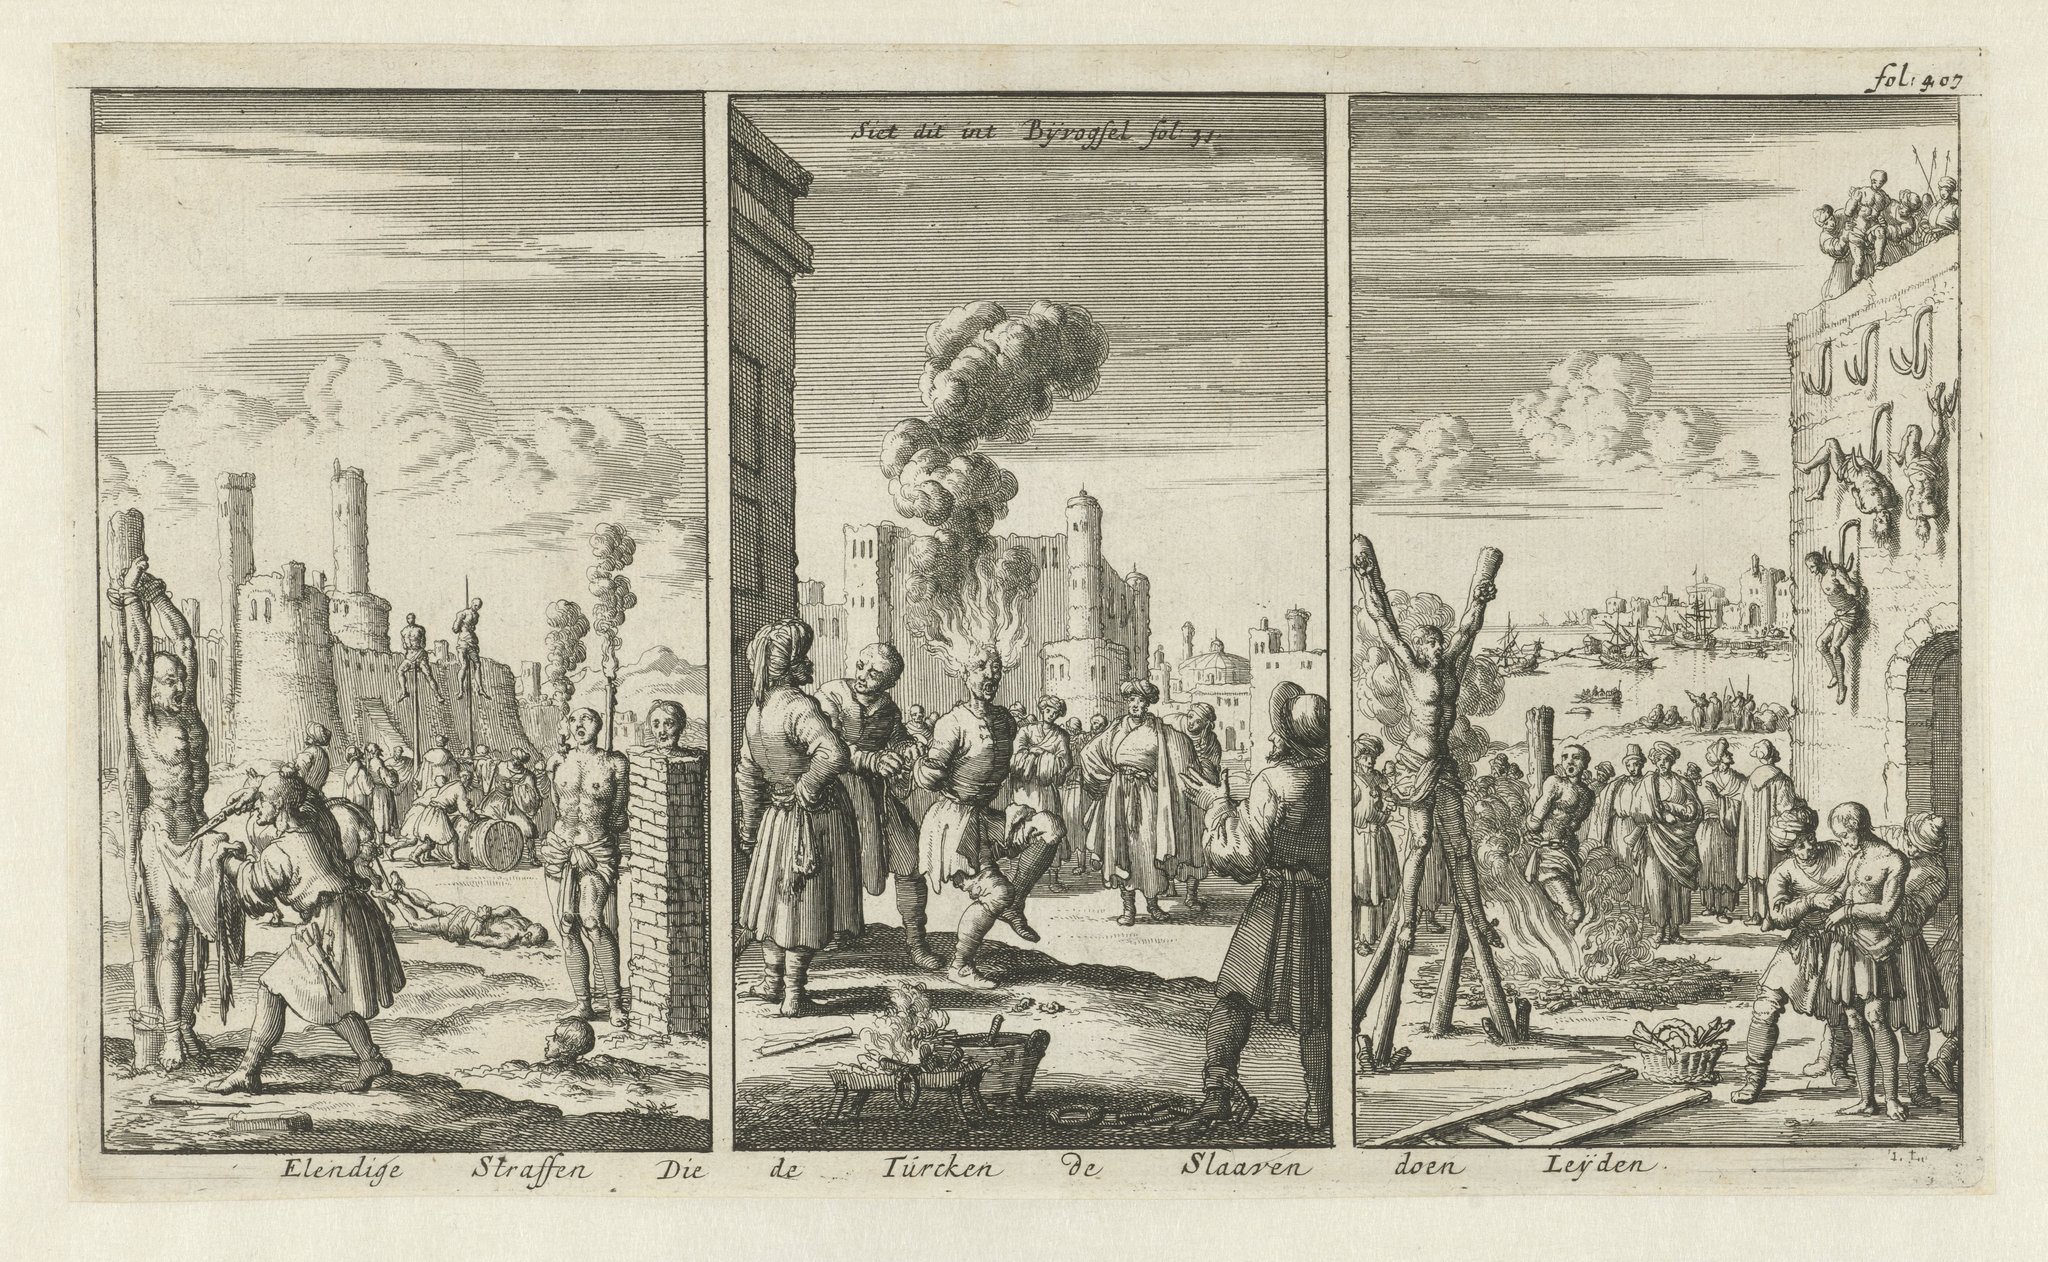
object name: print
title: Straffen voor christenslaven in Noord-Afrika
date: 1684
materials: paper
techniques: engraving, etching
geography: amsterdam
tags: death penalty, execution, slavery; serfs and enslaved persons, violent death ~ maltreatment, torture, torture, public punishment (death not intended or involved)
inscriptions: collector's mark: Lugt 2228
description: Drie voorstellingen van verschillende soorten straffen die aan christelijke slaafgemaakten in Noord-Afrika (christenslaven) zouden worden gegeven. Prent rechtsboven genummerd: fol: 407.